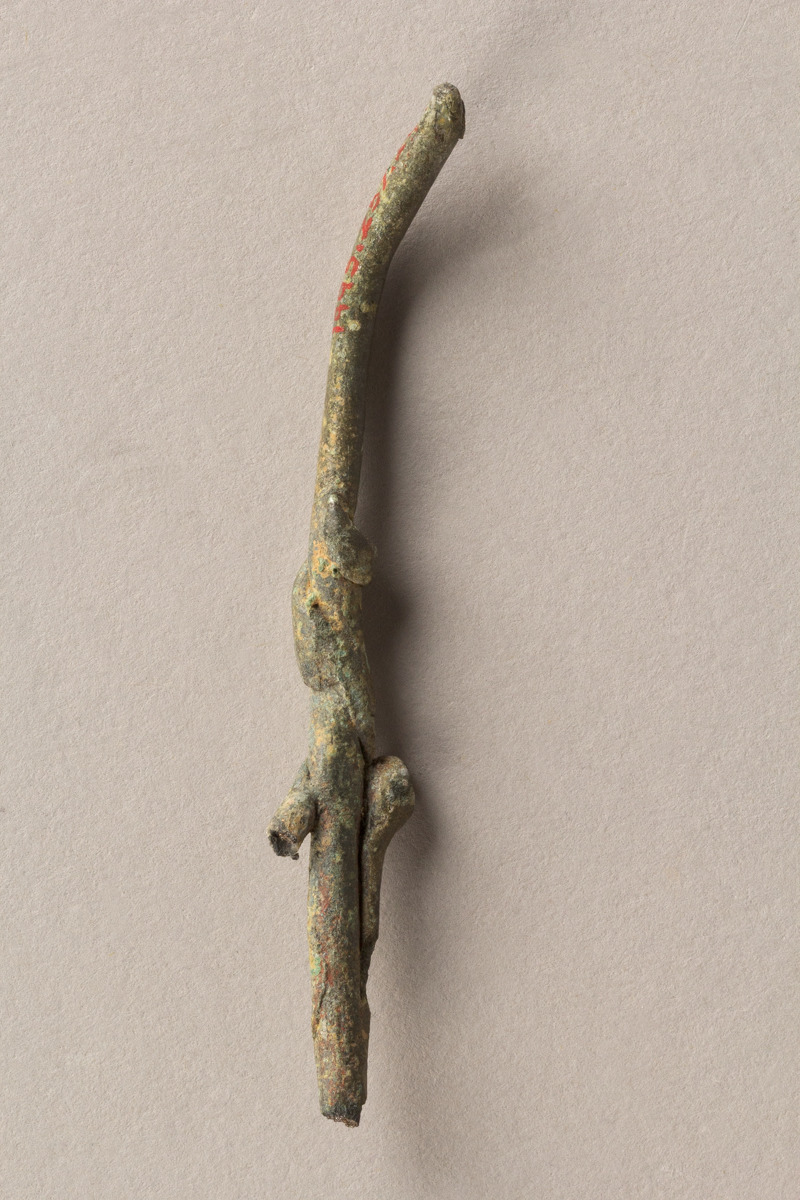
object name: fragment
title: Fragment of a Stem of a Flower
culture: indonesian, kalimantan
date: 701-800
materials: bronze